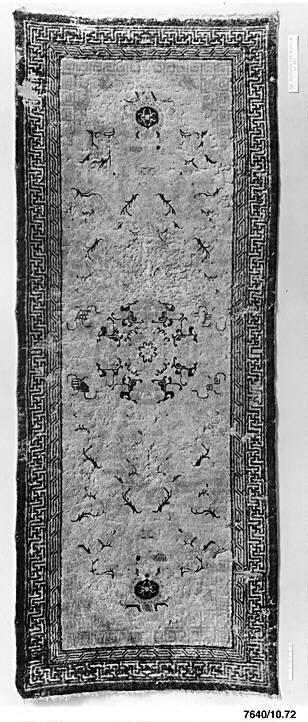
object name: rug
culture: chinese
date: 1701-1800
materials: cotton, wool